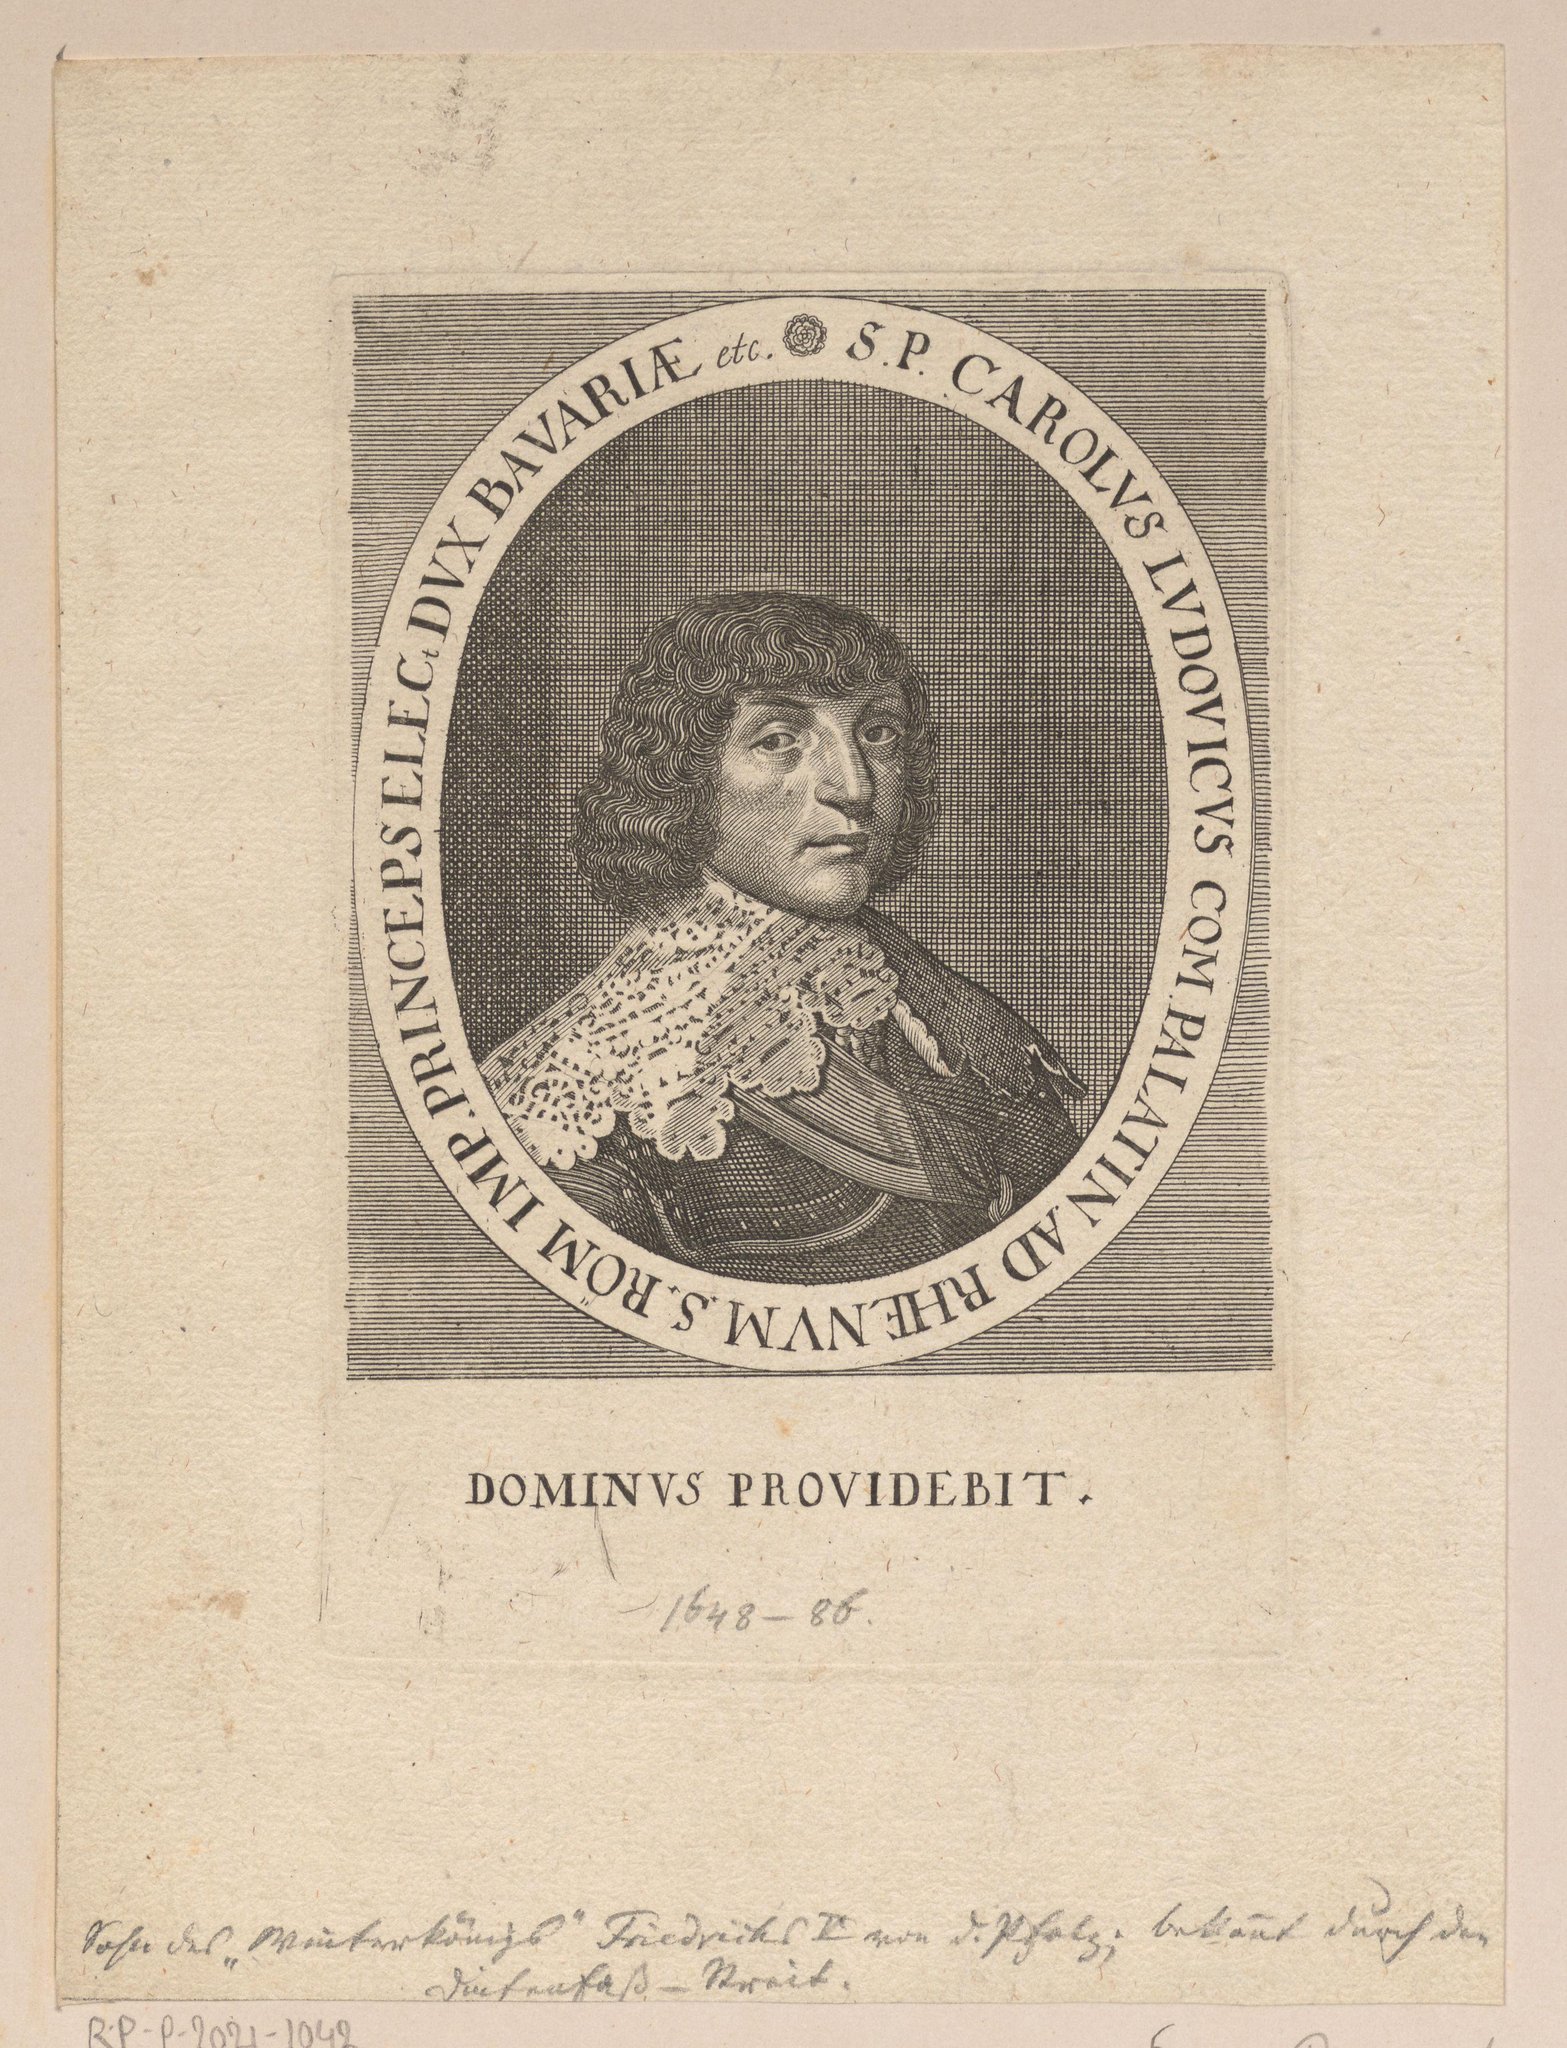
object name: print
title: Portret van Karel Lodewijk, keurvorst van de Palts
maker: Anonymous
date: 1650-1724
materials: paper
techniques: engraving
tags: historical persons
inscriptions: watermark